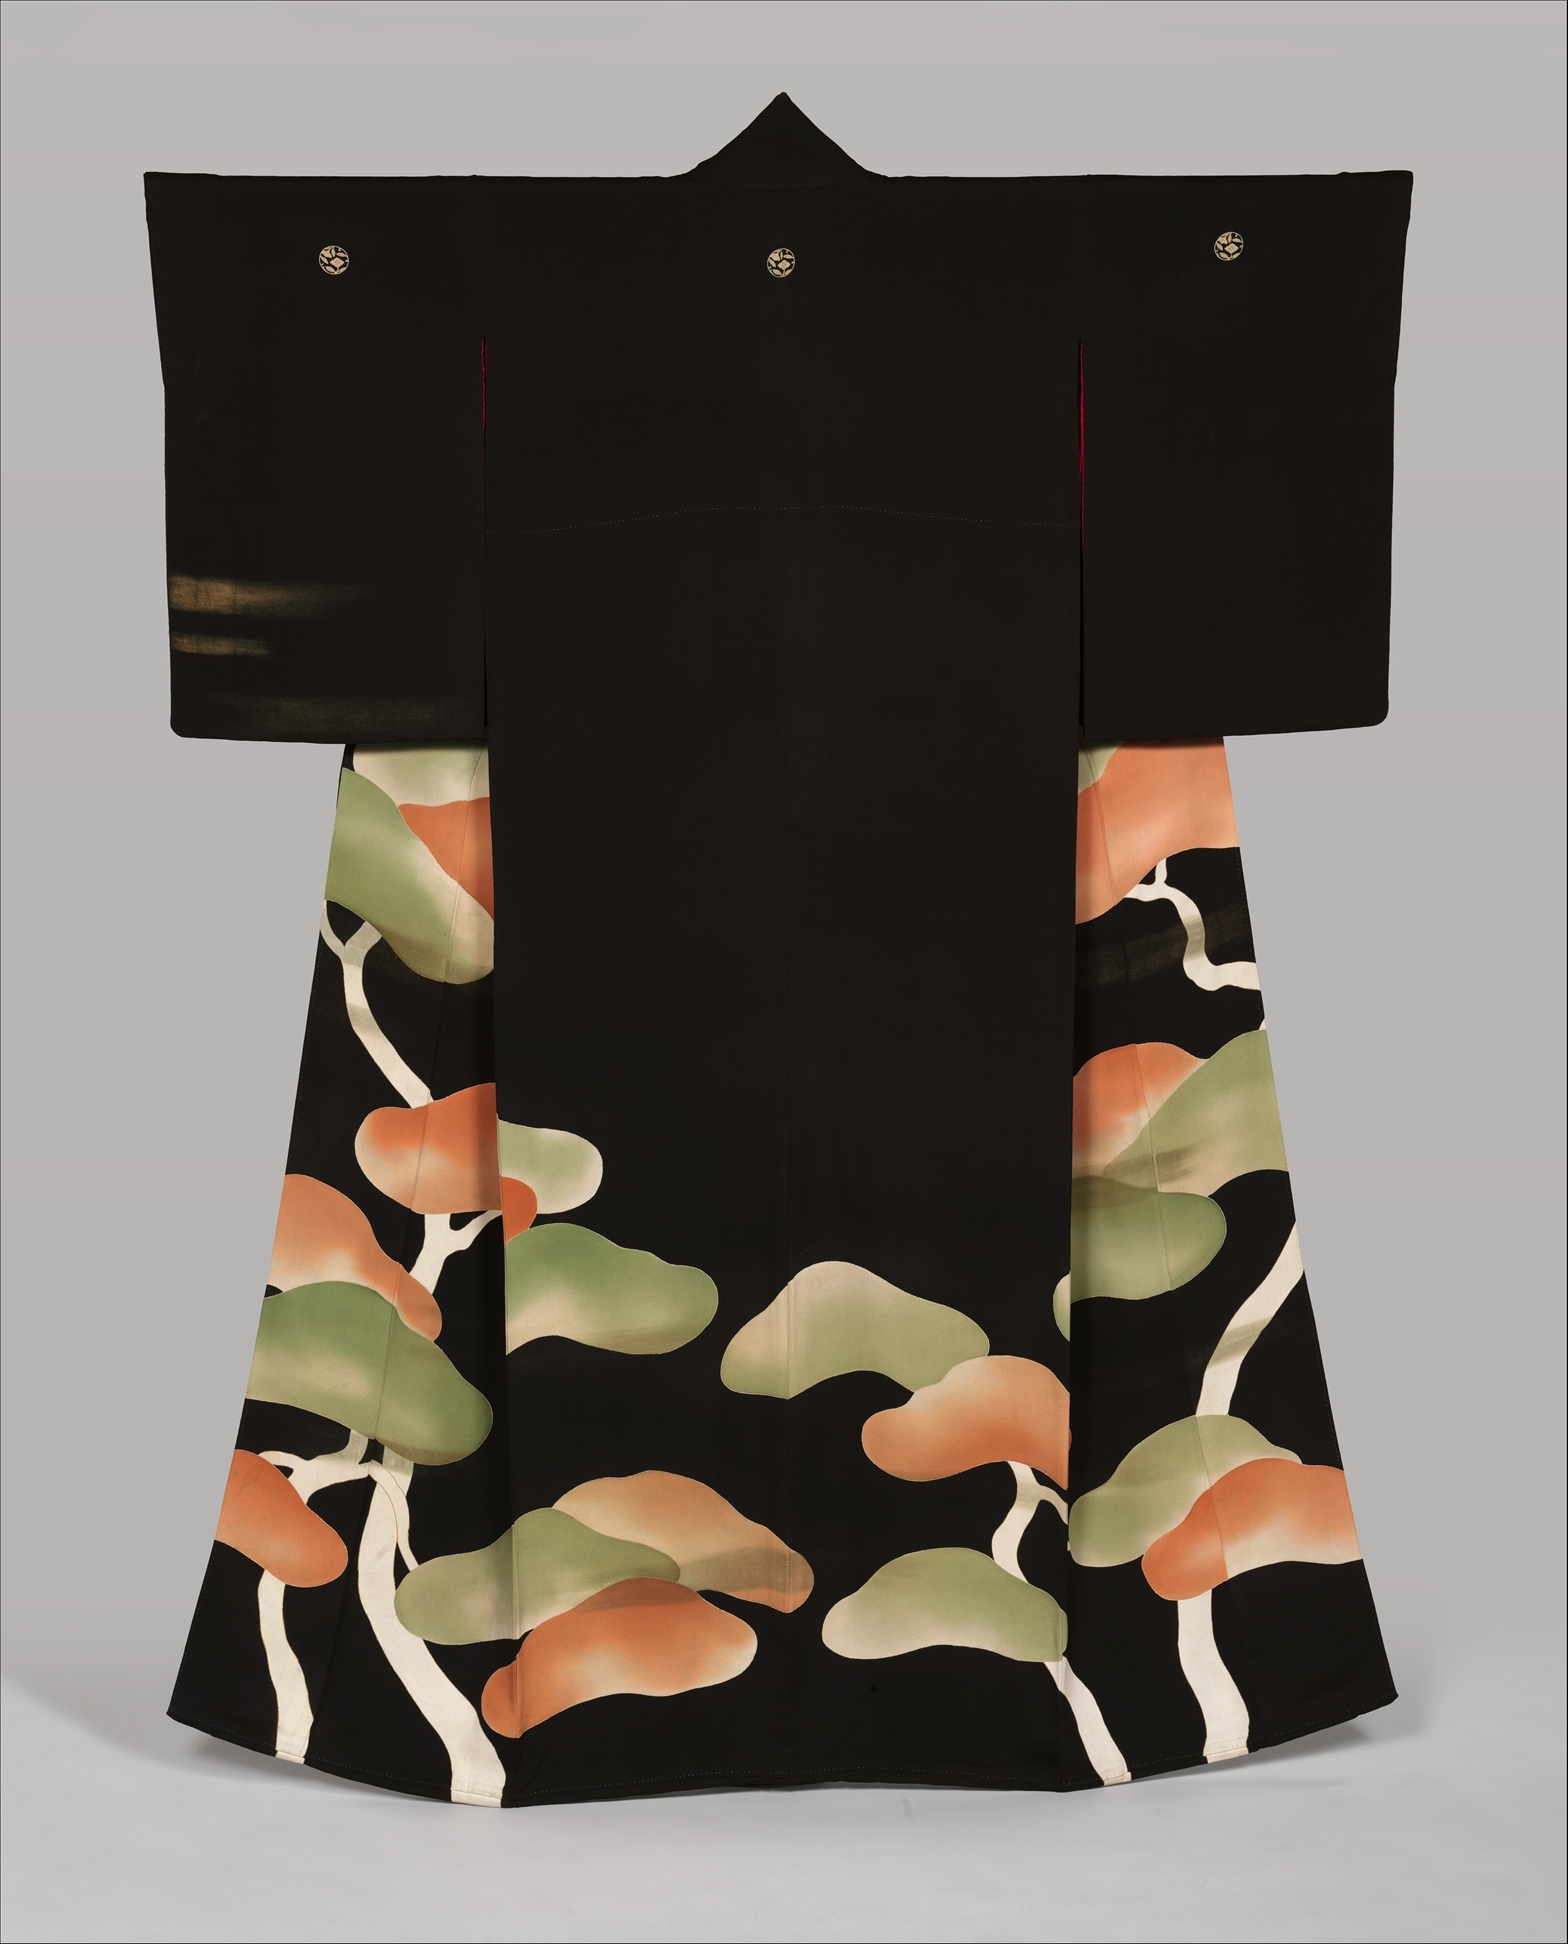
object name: kimono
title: Kimono with Pines and Mist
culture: japanese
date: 1926-1950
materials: gold, paste, silk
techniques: weave, resist